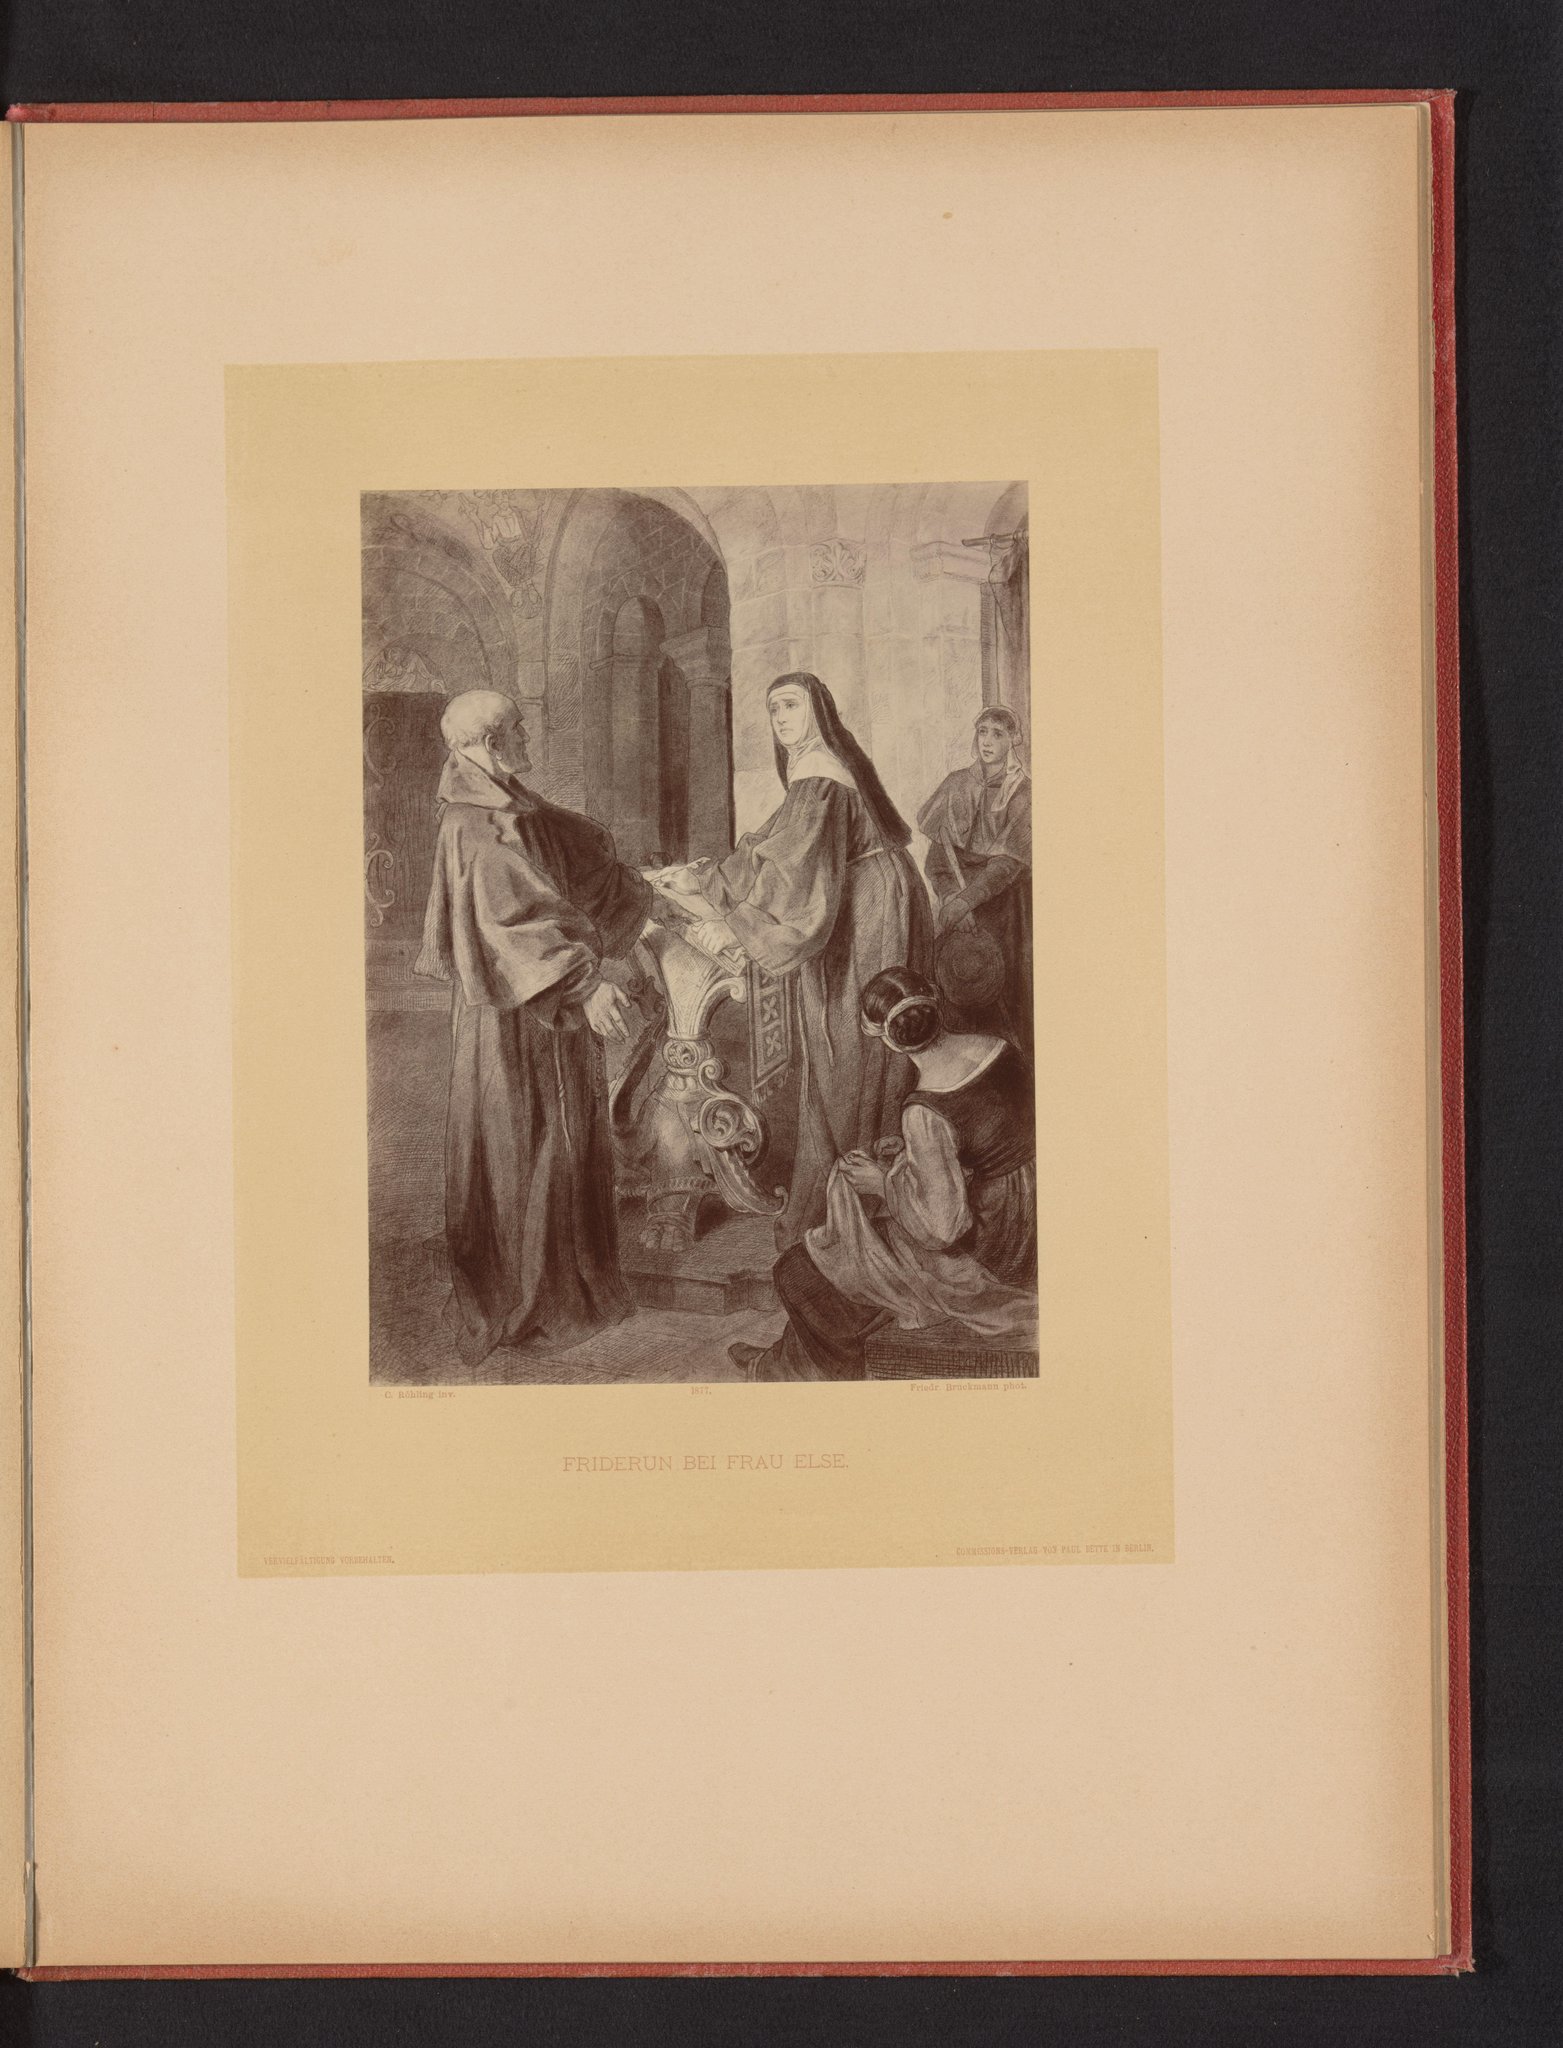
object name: photomechanical print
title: Reproductie van een tekening van een scene met Friderun en Frau Else uit Die Ahnen van Gustav Freitag, door Carl Röhling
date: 1877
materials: paper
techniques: woodburytype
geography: berlin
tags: monks and nuns, specific works of literature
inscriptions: inscription: ‘VERVIELFÄLTIGUNG VORBEHALTEN.’